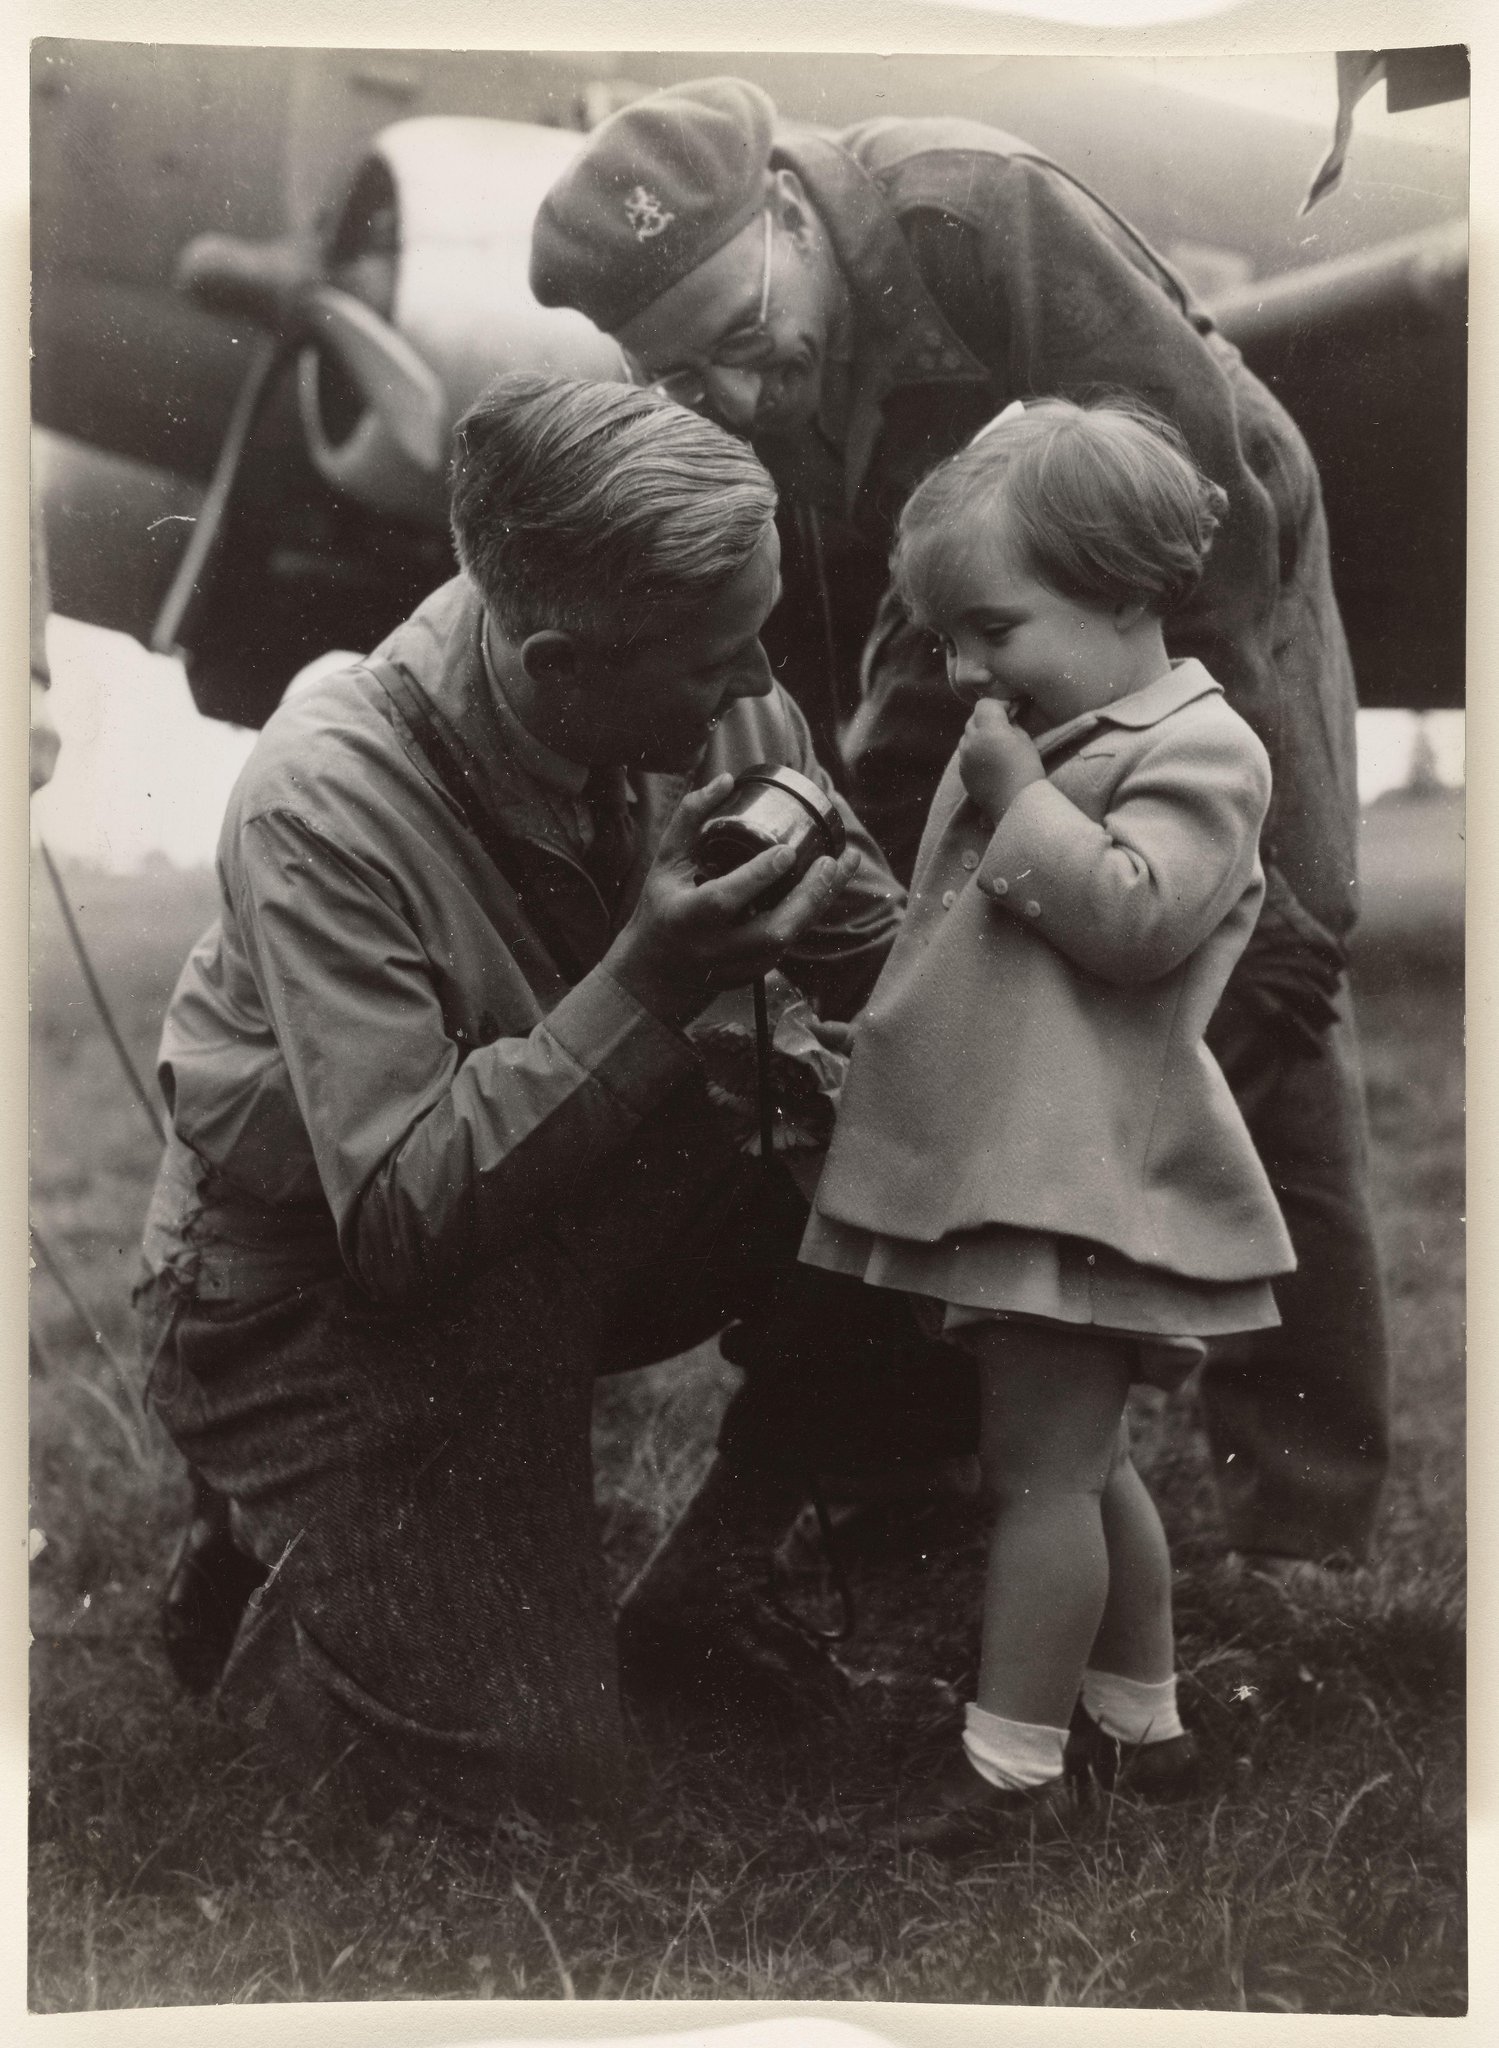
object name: photograph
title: Prinses Margriet weer thuis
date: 1908-1945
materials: photographic support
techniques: photography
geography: netherlands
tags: utrecht, bernhard (prins der nederlanden), netherlands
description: Prinses Margriet met een militair. Een verslaggever tracht haar wat vergeefs te ontlokken. Op de achtergrond een vliegtuig. De prinsesjes zijn terug in Nederland.